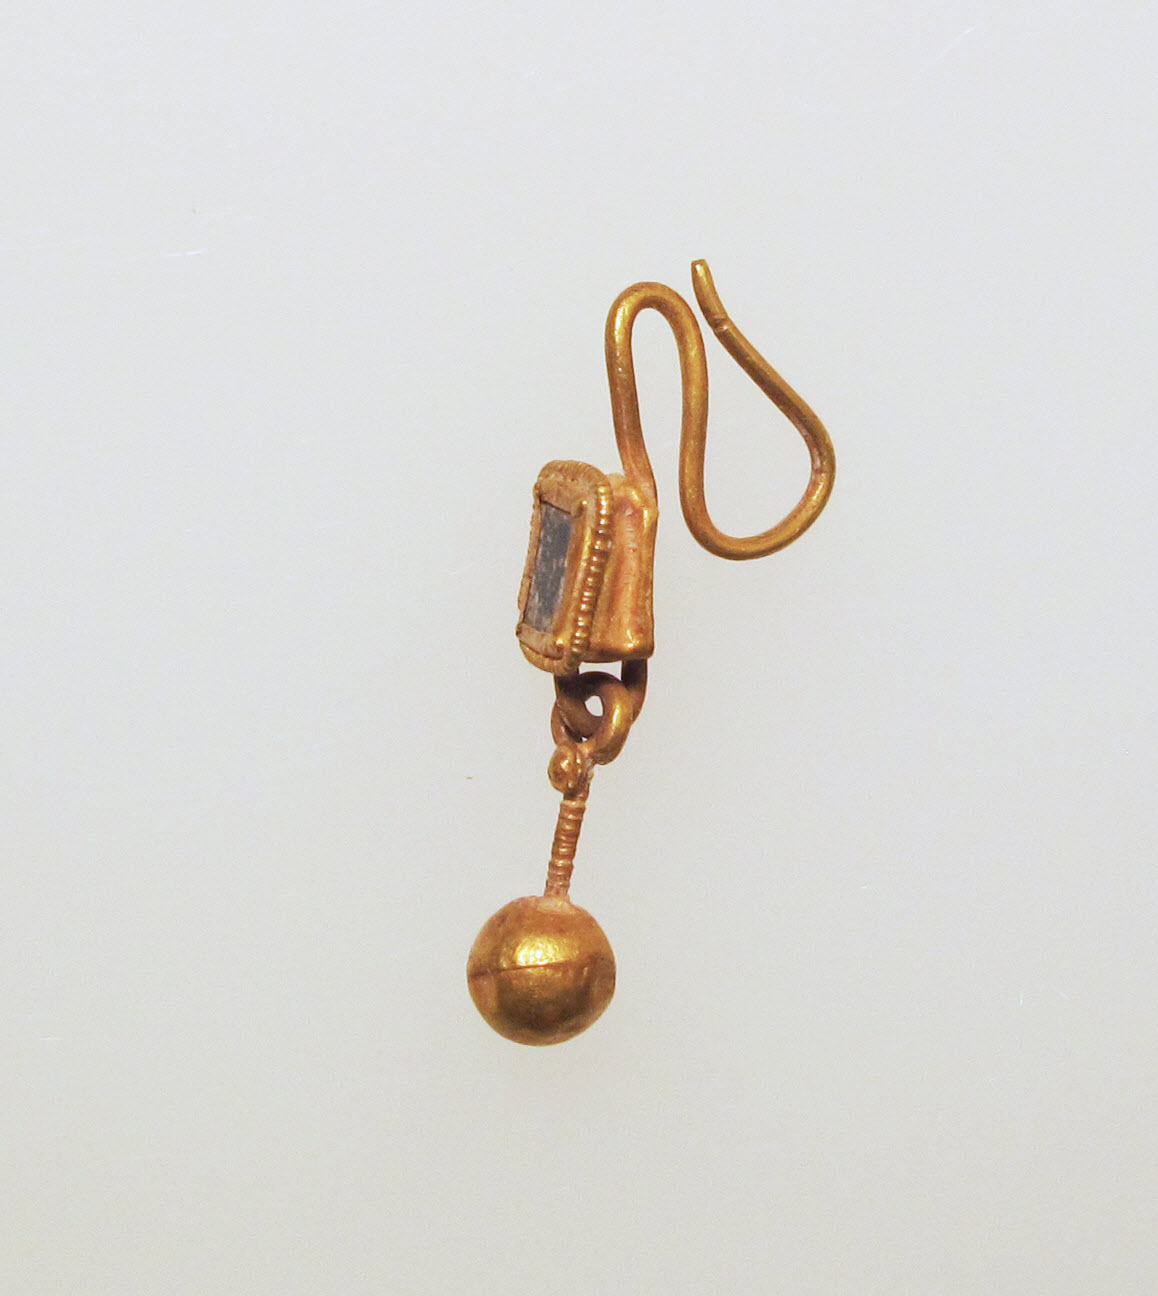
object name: earring hook type with pendant and paste setting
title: Earring-hook type with pendant and paste setting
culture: roman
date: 101-200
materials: glass, gold, paste